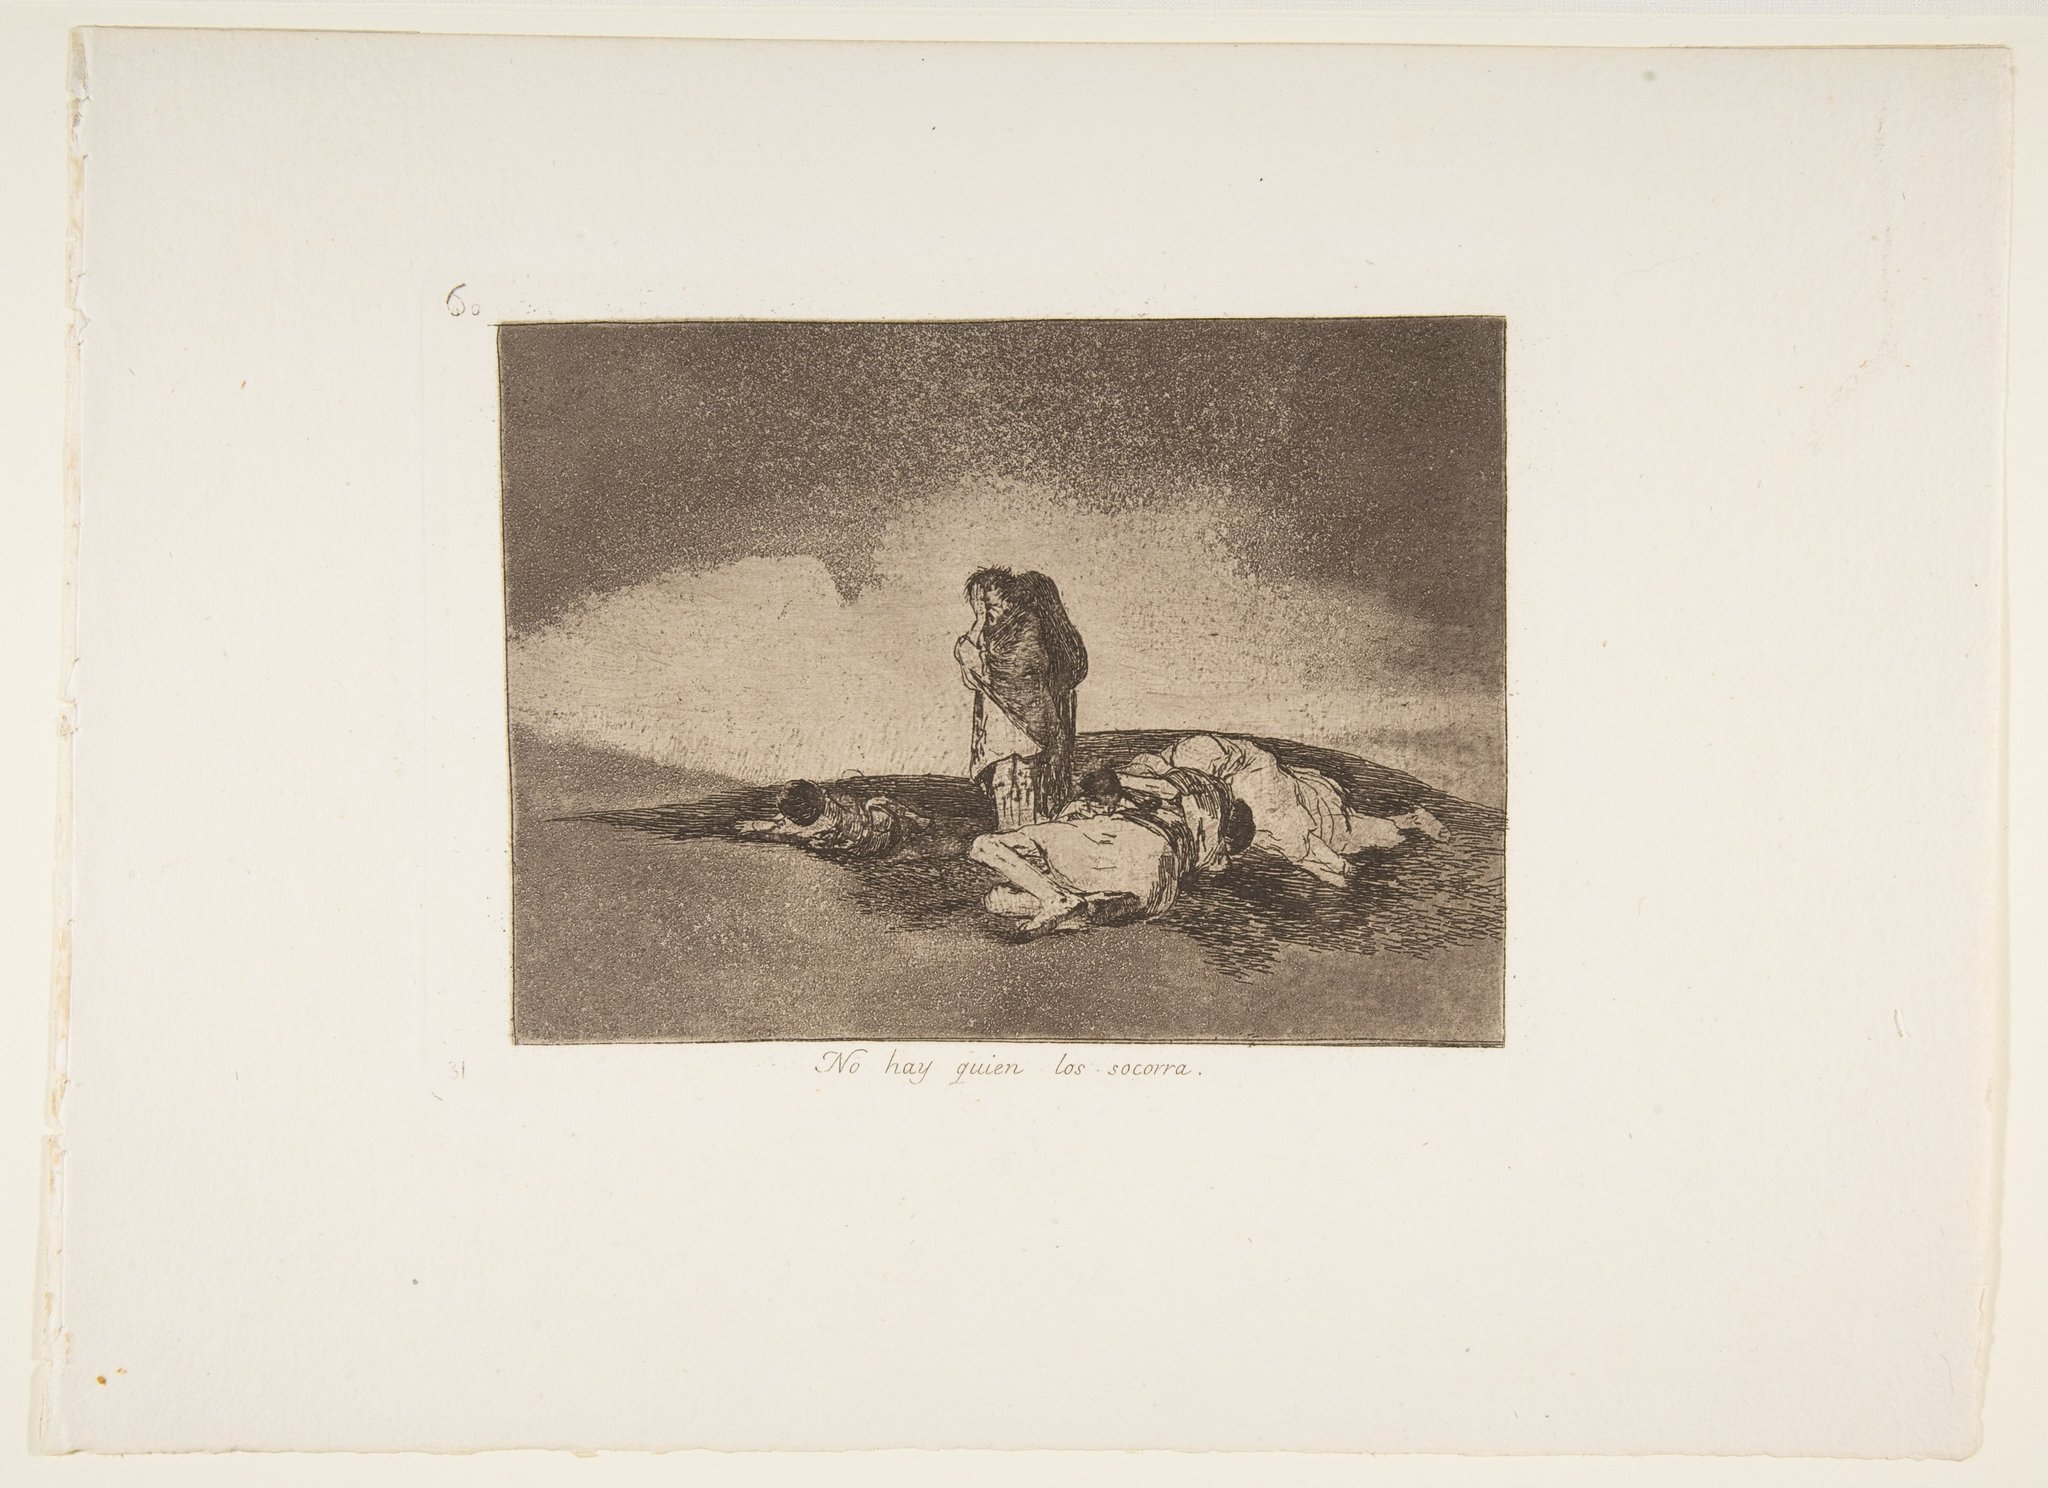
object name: print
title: Plate 60 from "The Disasters of War" (Los Desastres de la Guerra): 'There is no one to help them' (No hay quien los socorra)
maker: goya (francisco de goya y lucientes)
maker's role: artist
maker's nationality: spanish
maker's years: 1746-1828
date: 1811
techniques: aquatint, engraving, burnishing, etching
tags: human figures,death